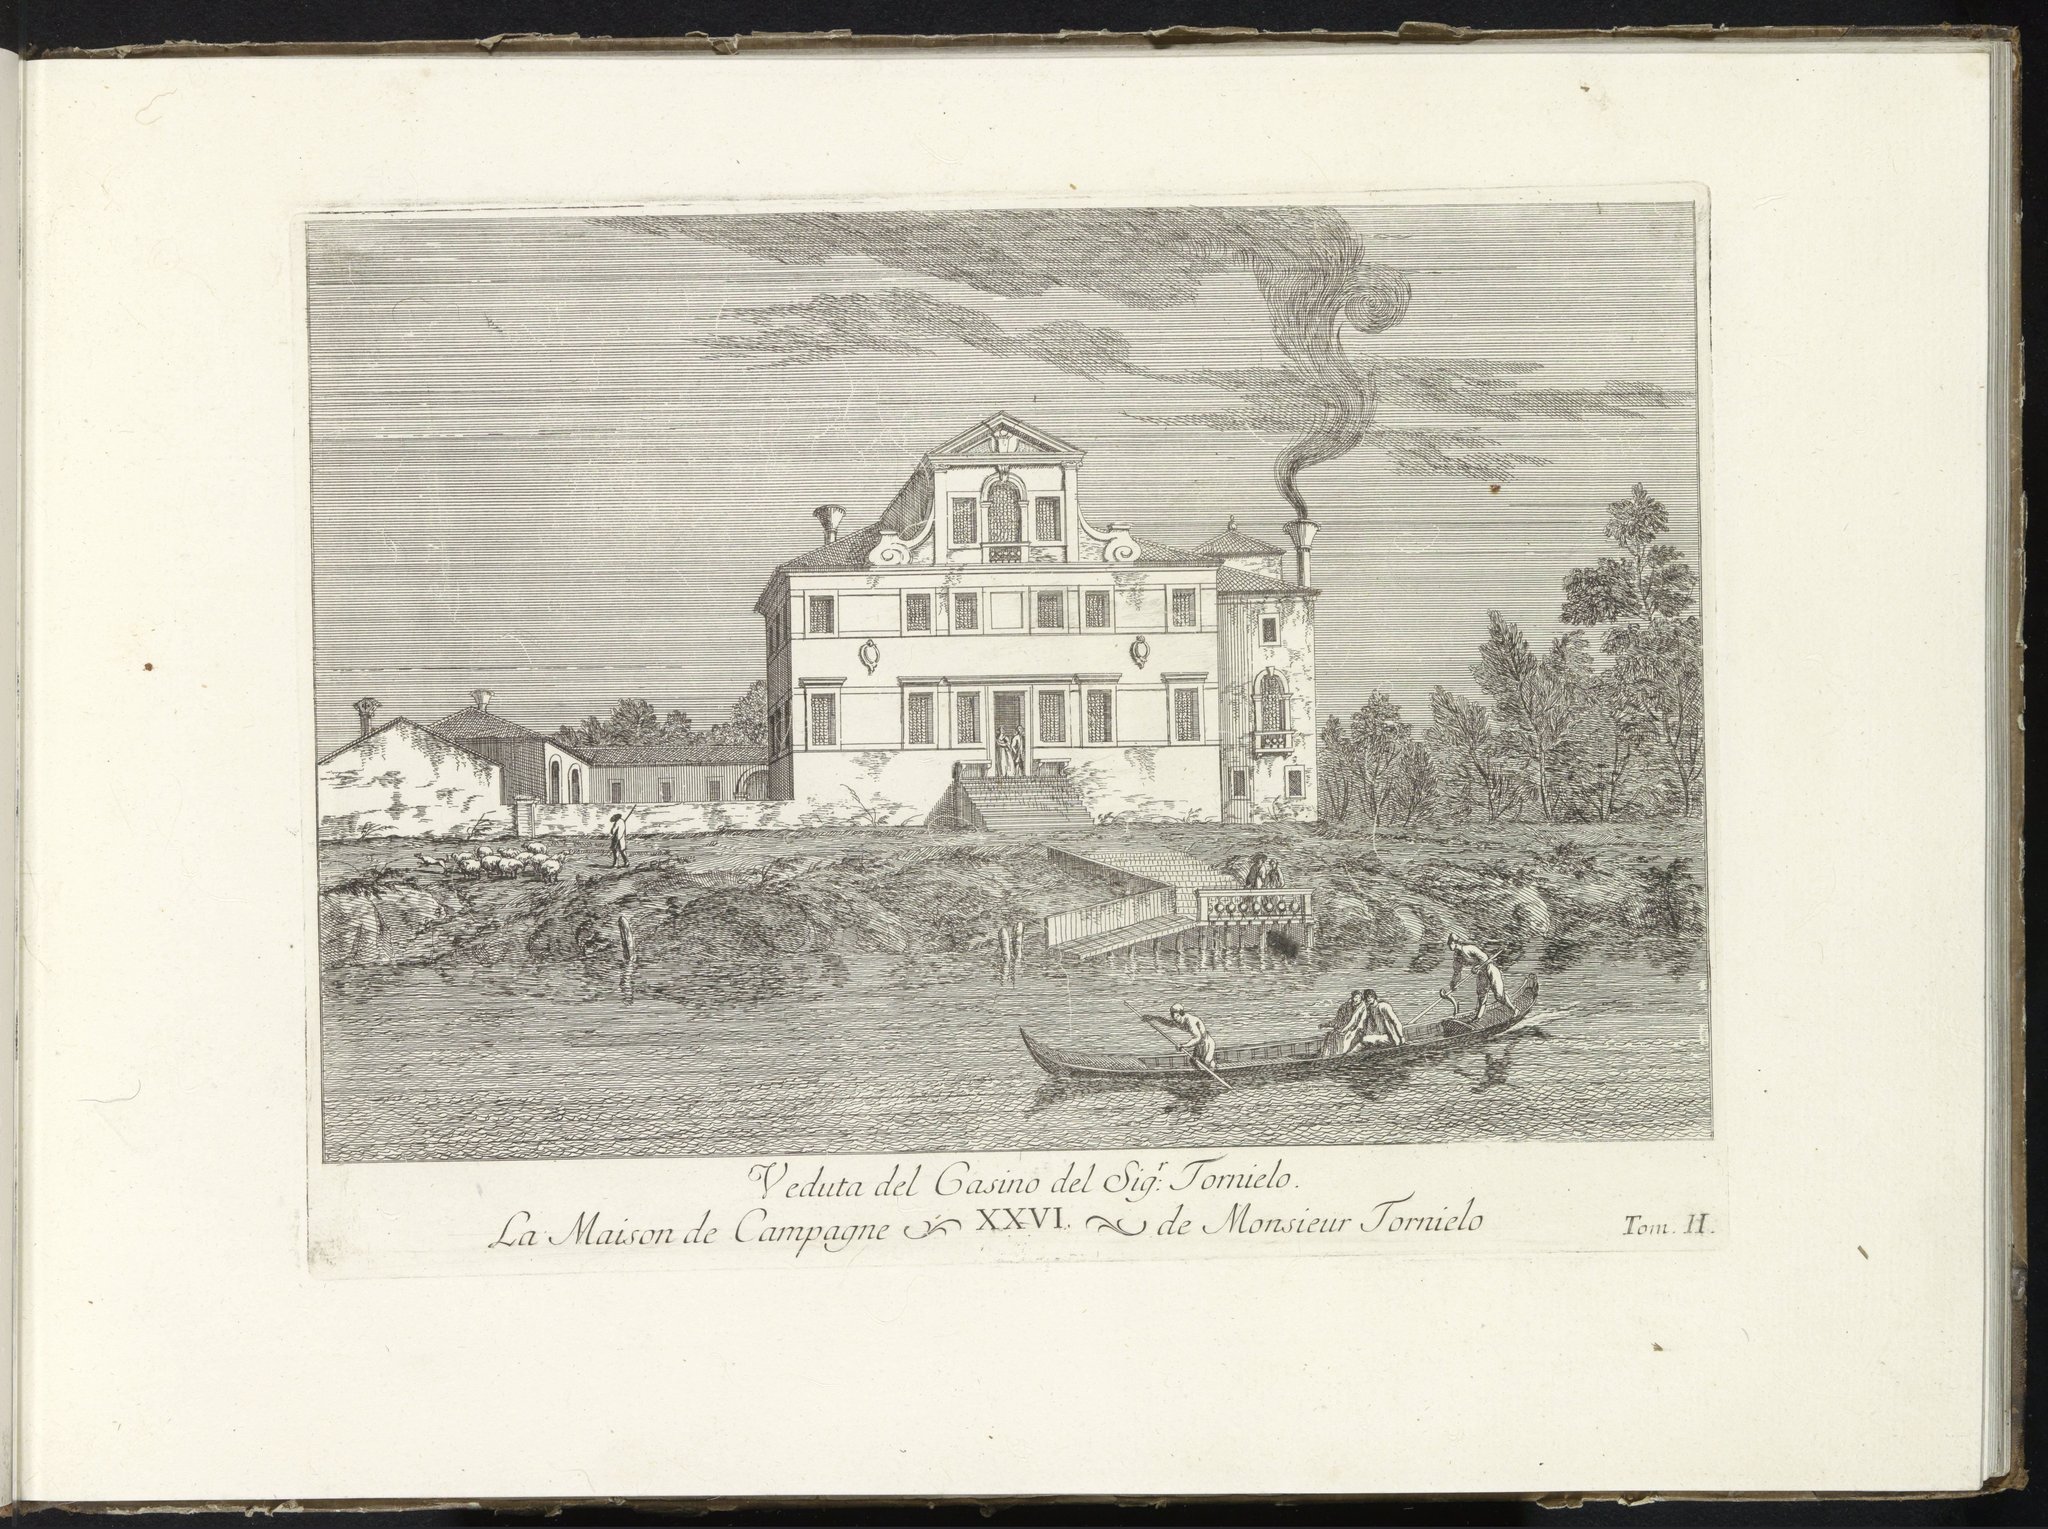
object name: print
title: Le delicie della Brenta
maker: giovanni francesco costa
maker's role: draughtsman, painter, print maker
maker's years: -1773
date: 1750-1760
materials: paper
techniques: etching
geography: venice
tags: river, herding, herdsman, herdswoman, shepherd, shepherdess, cowherd, etc., hôtel, i.e. small palace in city, gondola, herd, flock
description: Gezicht op Casino del Signore Tornielo aan de rivier de Brenta. Op het water vaart een gondel. Aan de waterkant loopt een herder met zijn kudde schapen. Genummerd midden onder: XXVI en rechtsonder: Tom: II. Deze prent maakt deel uit van een album.